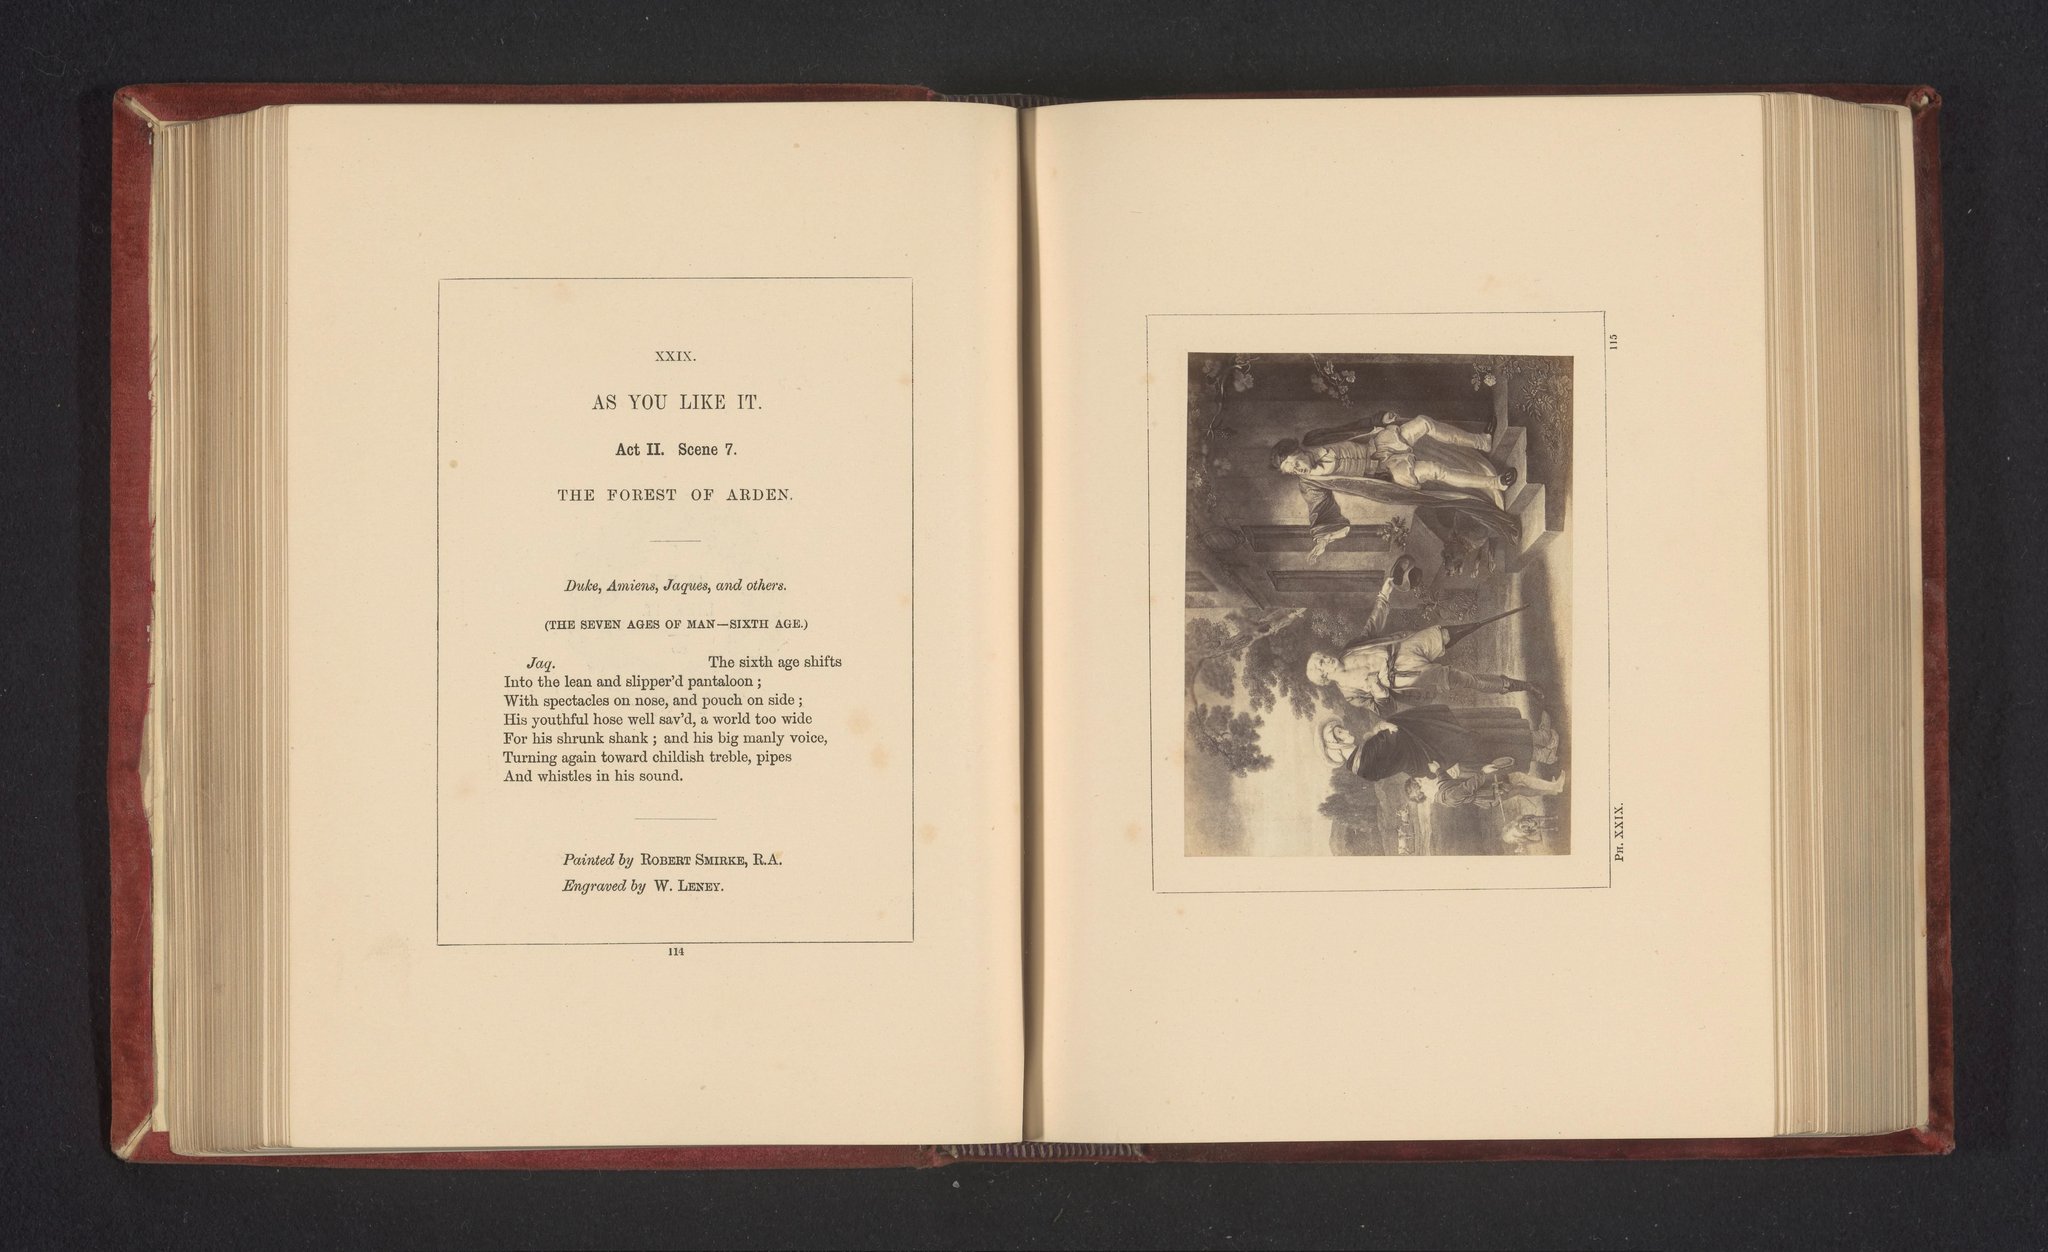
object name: photograph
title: Fotoreproductie van een prent naar een schilderij door Robert Smirke, voorstellend een scene uit Naar het u bevalt door William Shakespeare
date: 1854-1864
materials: photographic support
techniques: albumen print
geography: london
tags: specific works of literature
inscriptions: number: ‘Ph. XXIX. 115’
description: Te zien is een verbeelding van akte II, scene 7; Seven Ages Of Man.